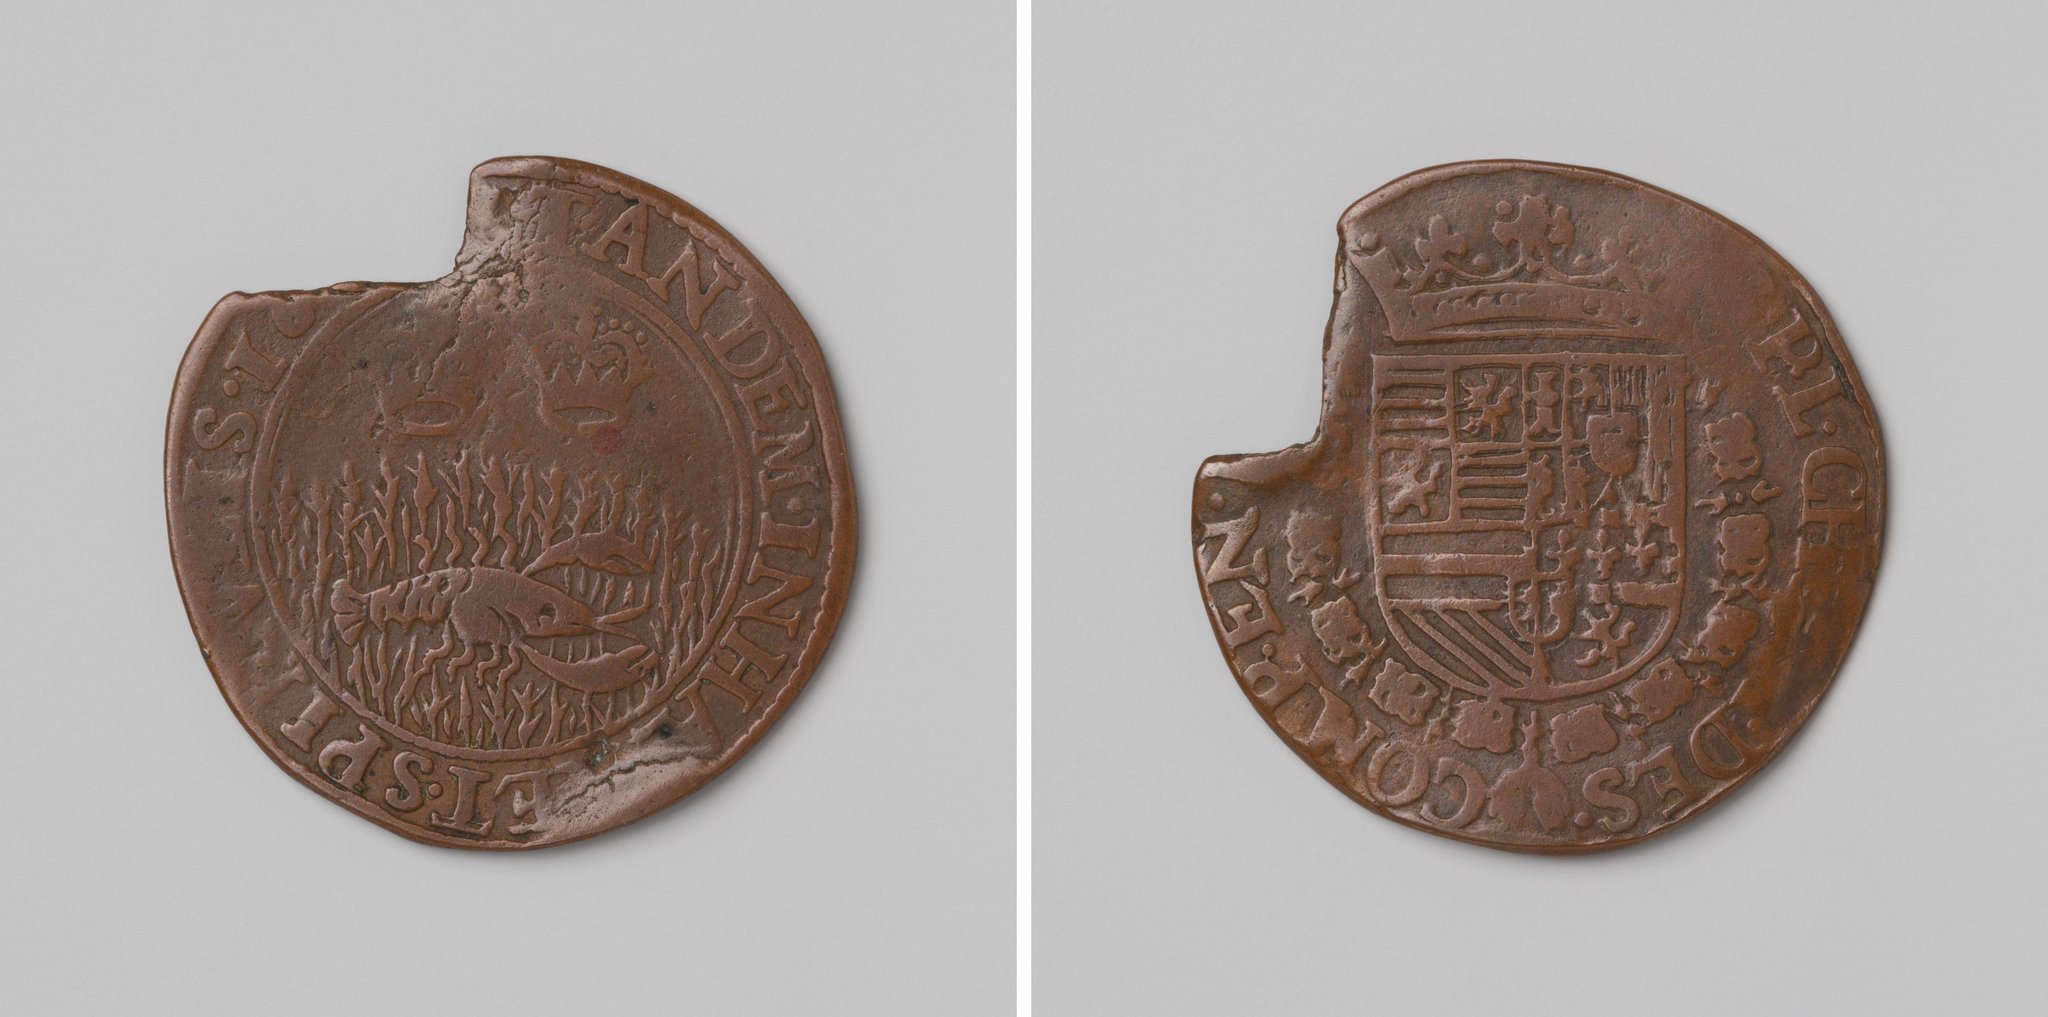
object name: jeton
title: Overgave van Oostende, rekenpenning van de rekenkamer van Brabant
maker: Anonymous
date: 1604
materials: copper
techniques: striking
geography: antwerp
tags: infante van spanje isabella clara eugenia, brussels, albrecht aartshertog van oostenrijk, brabant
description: Koperen penning. Voorzijde: kreeft temidden van doornstruiken, refererend aan veldheer Spinola, onder twee kronen binnen omschrift. Keerzijde: gekroond wapenschild, omhangen met de orde van het Gulden Vlies binnen omschrift